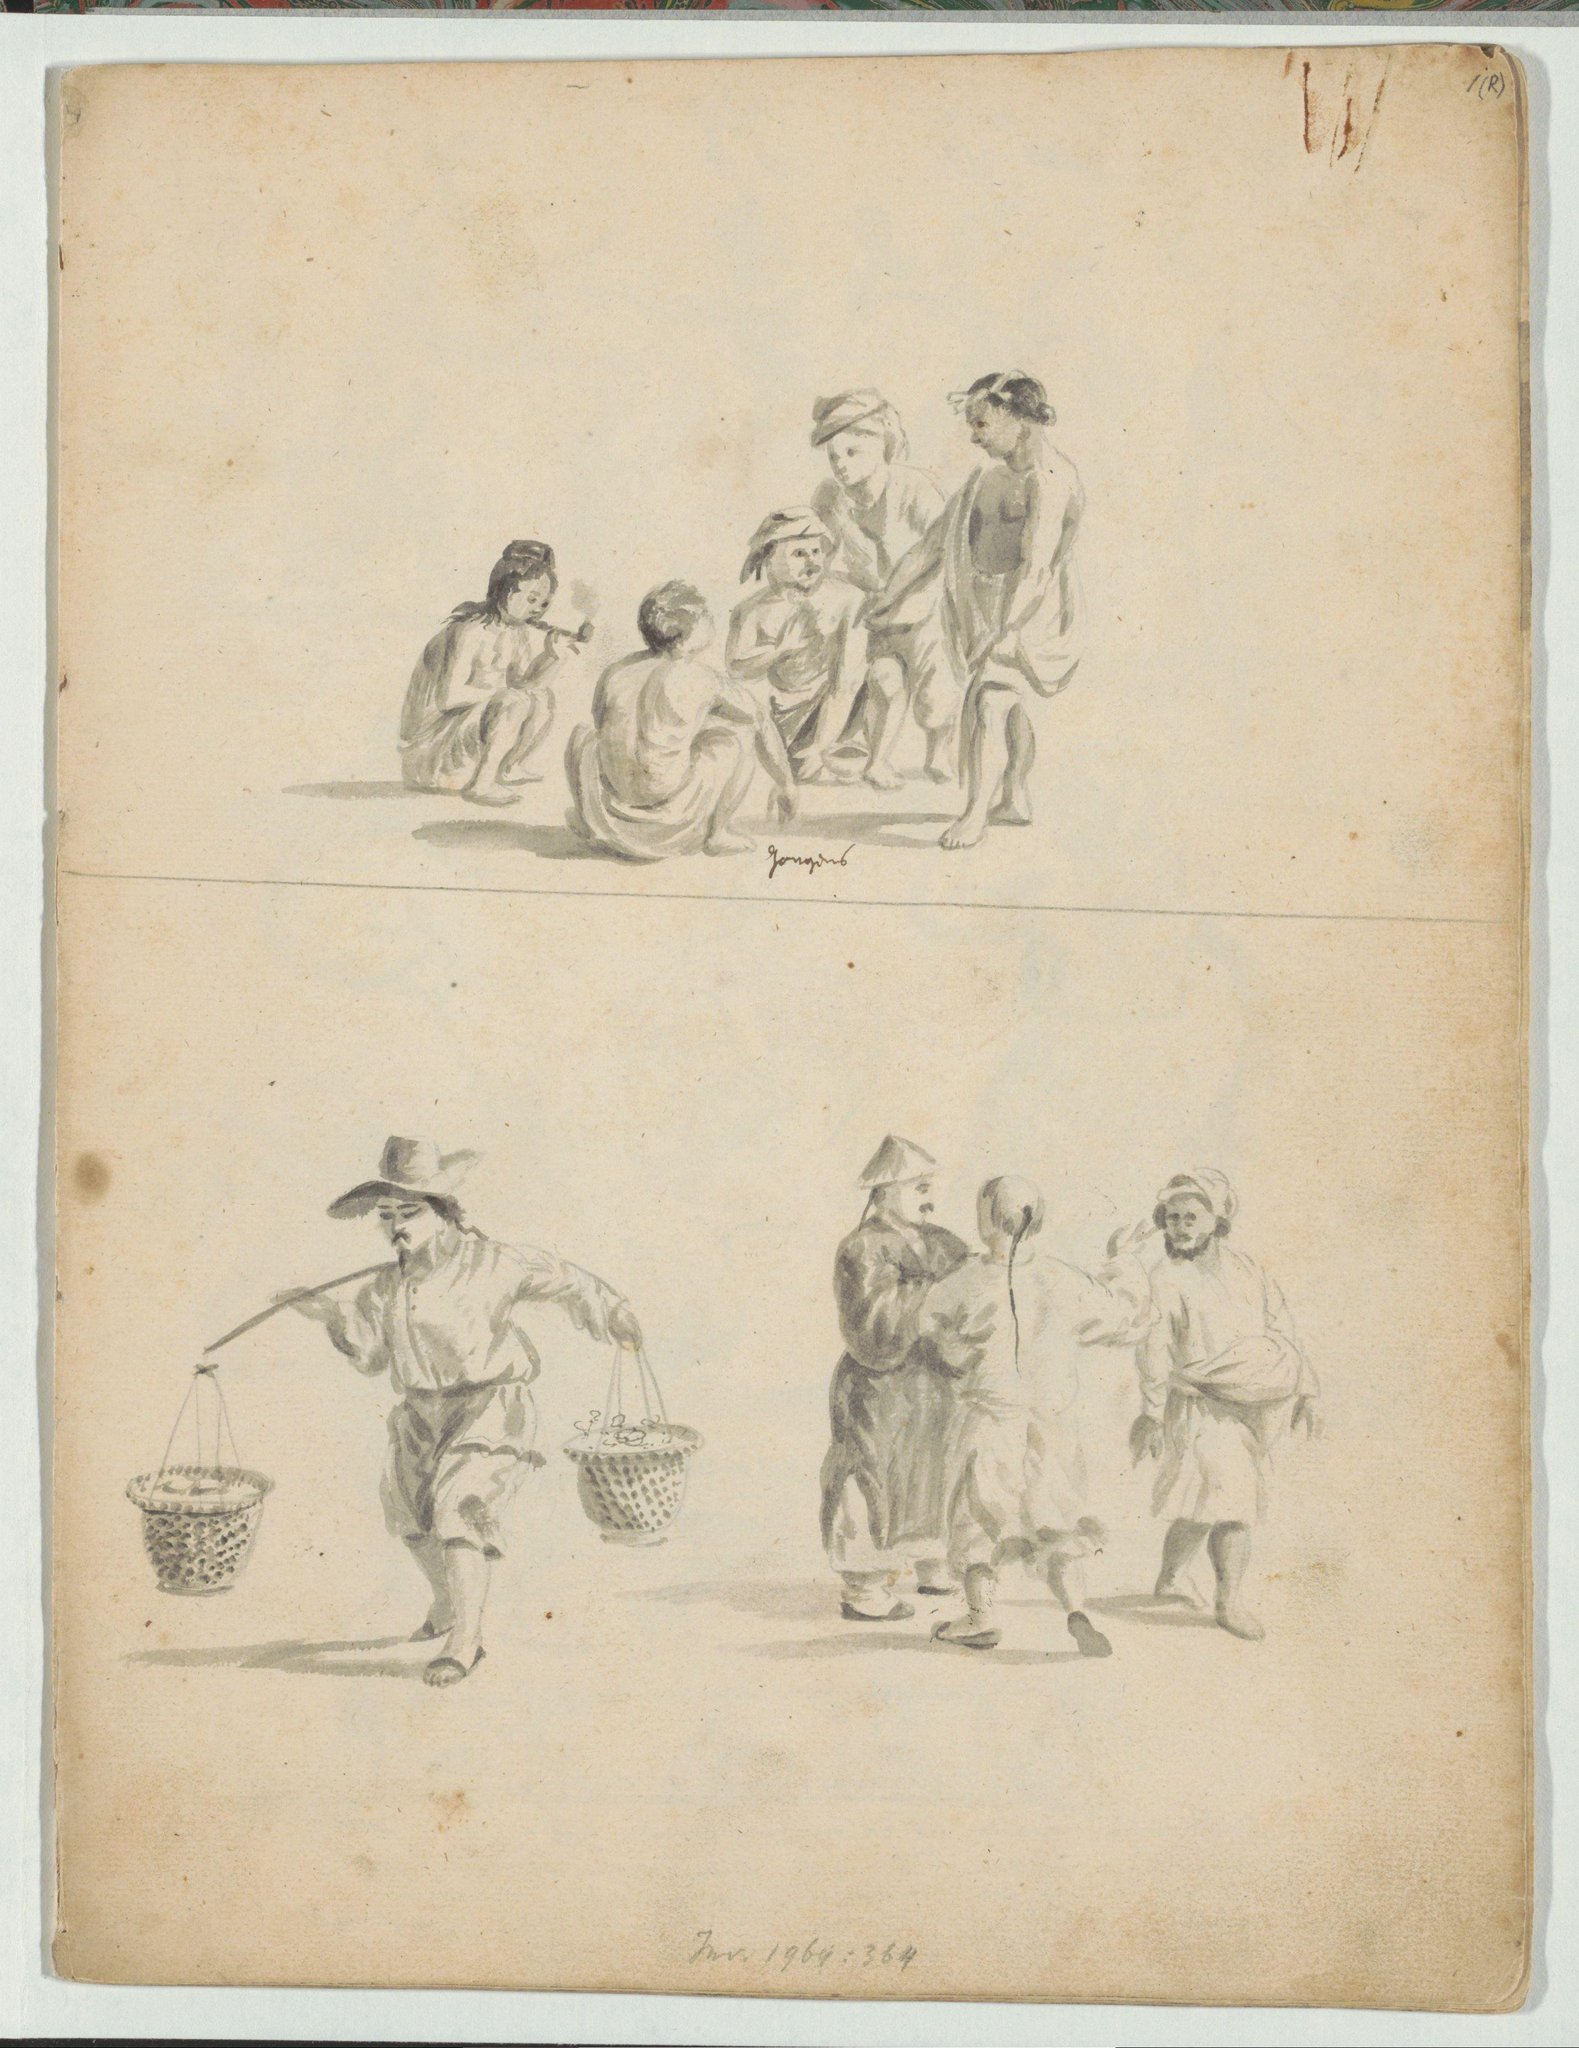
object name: sketchbook leaf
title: Studieblad met jongens, mannen in gesprek en een man met een juk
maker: wouter schouten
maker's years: 1638-1704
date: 1660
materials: ink, paper, pencil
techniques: brush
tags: asiatic races and peoples (indonesians), head (human), asiatic races and peoples (with name), carrying something with yoke, china, indonesia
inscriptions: annotation: ‘Jongens’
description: De groep jongens draagt lendendoeken. Eén van hen rookt een pijp. Tevens een studie van drie mannen in gesprek. Een vierde man, die twee manden aan een juk draagt, loopt van hen weg. Blad 1 recto van een katern van 10 bladen afkomstig uit een schetsboek.